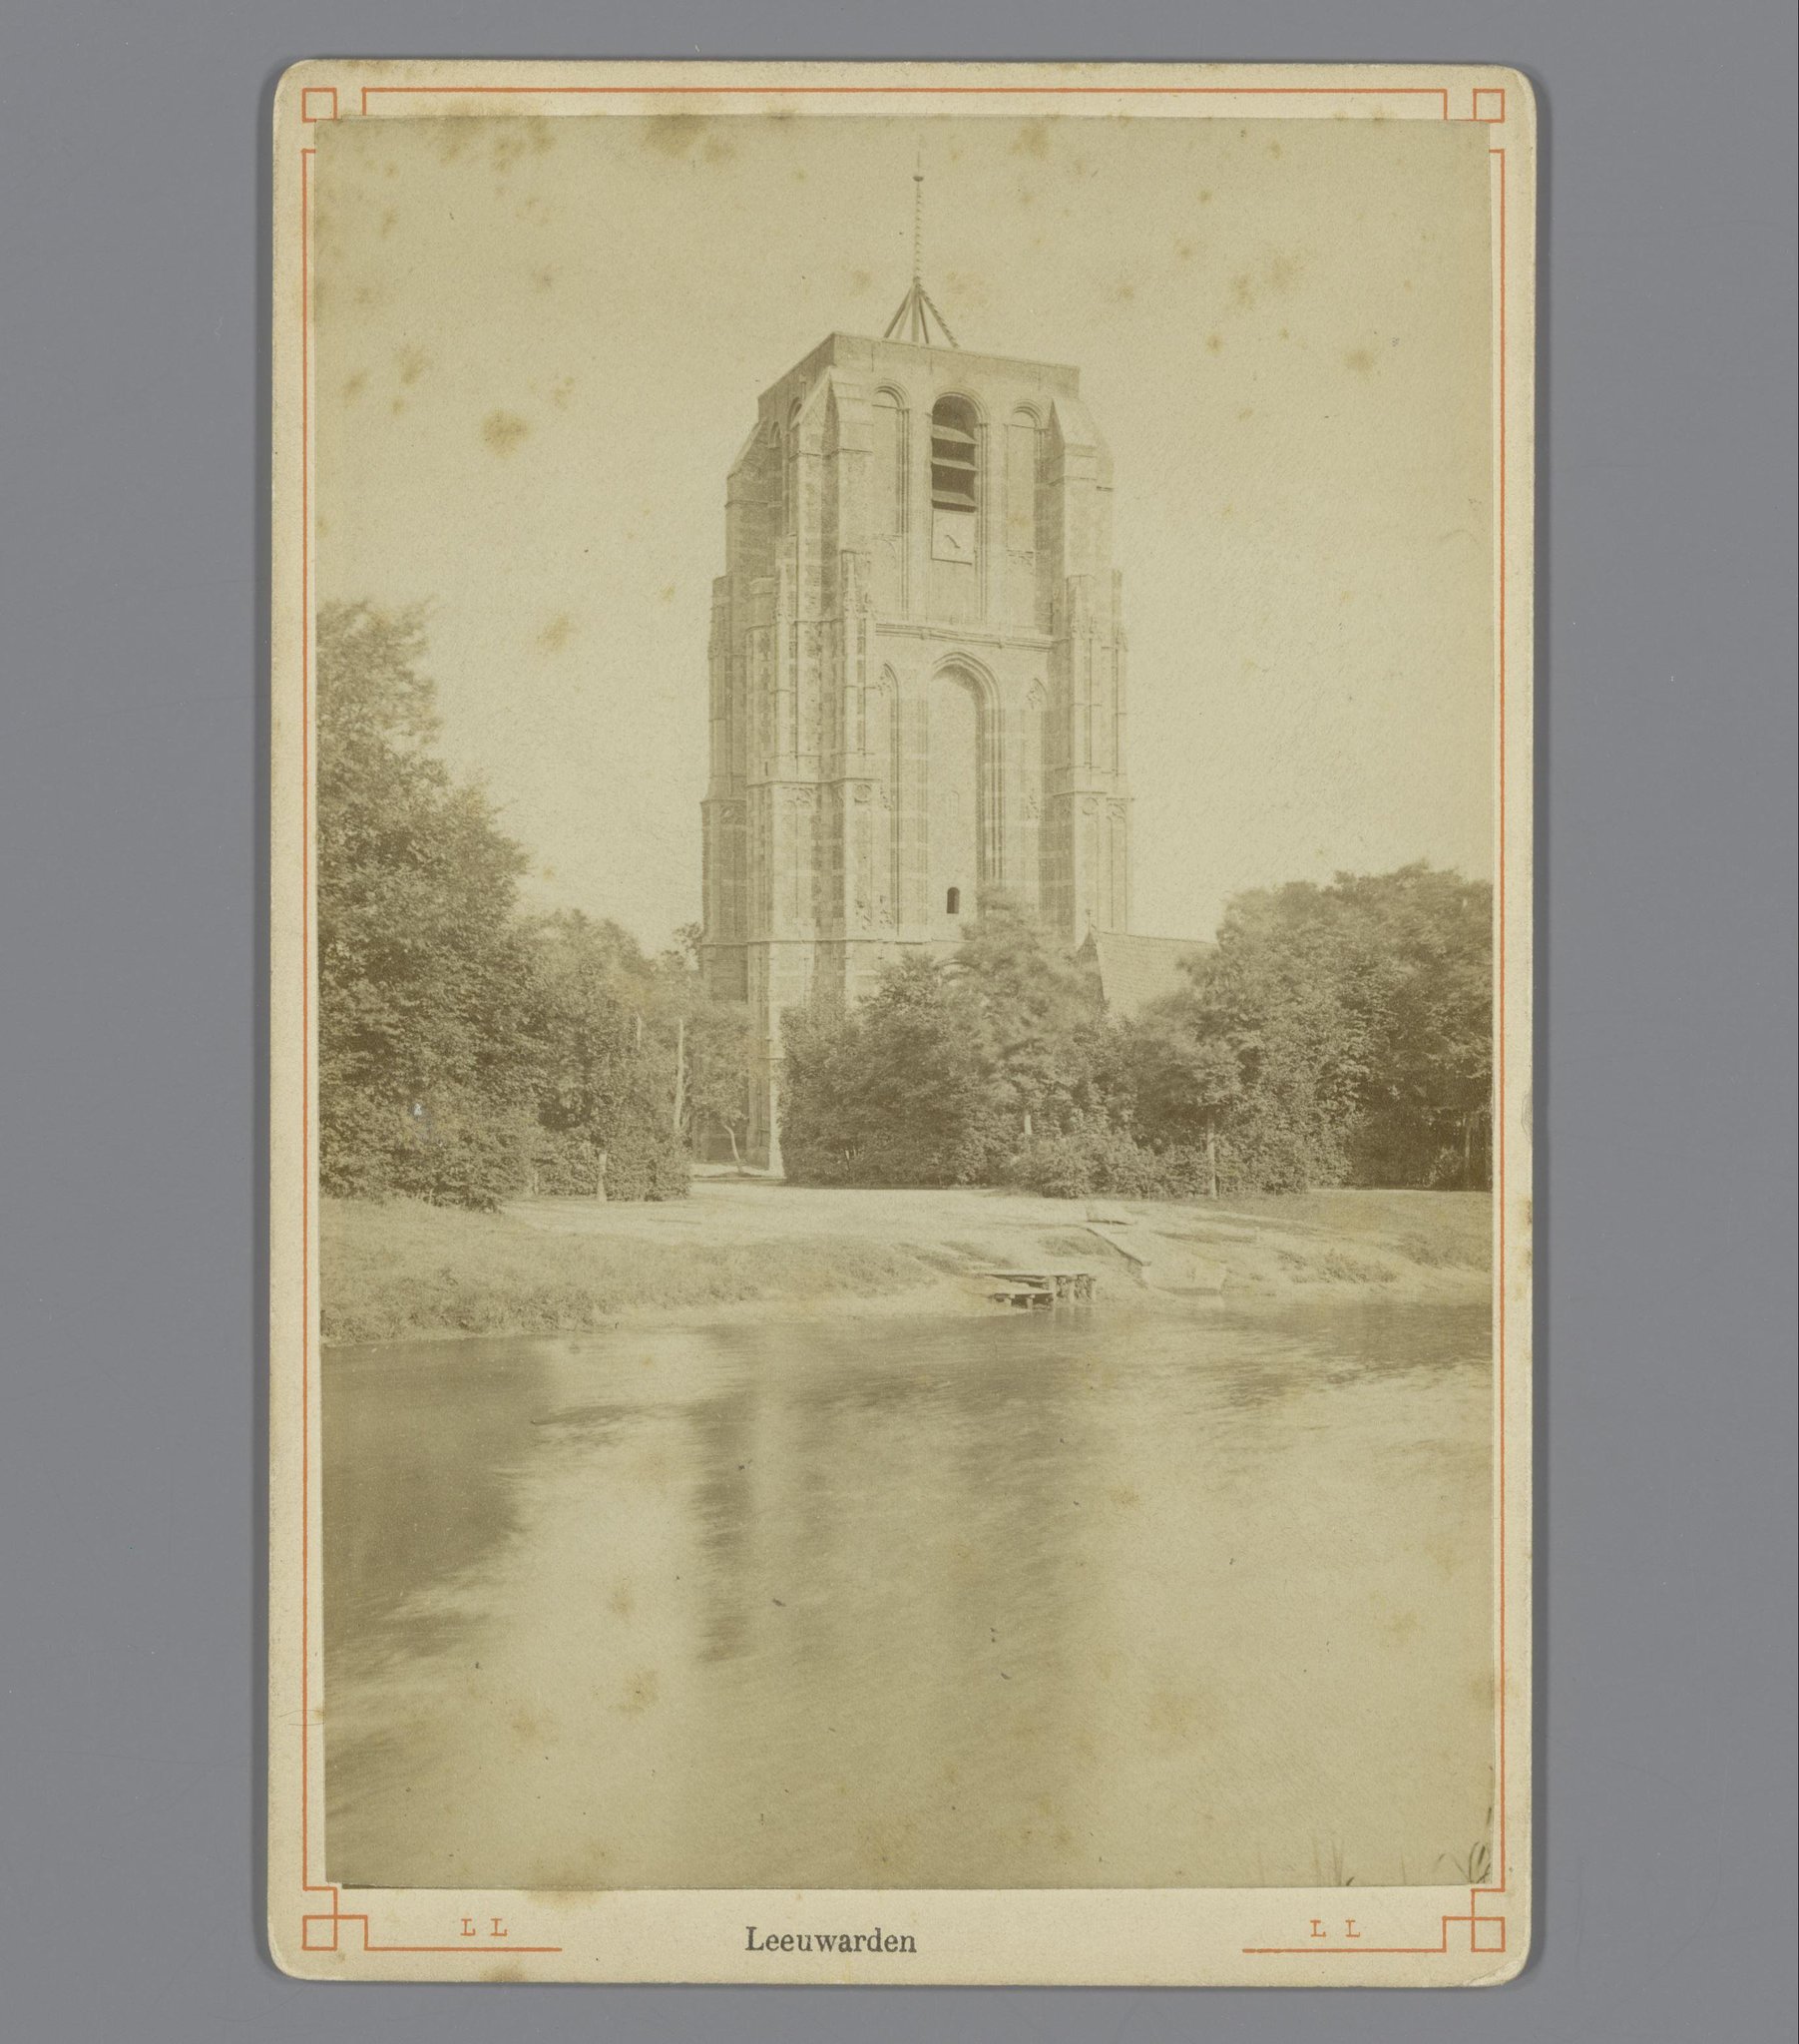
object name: photograph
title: Gezicht op de Oldehove te Leeuwarden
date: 1864-1900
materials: cardboard, photographic support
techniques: albumen print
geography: leeuwarden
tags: parts of church exterior and annexes: tower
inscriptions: inscription: ‘L L/ Leeuwarden/ L L’, retailer's mark: ‘S. SMEDING / Boekhandel / LEEUWARDEN’